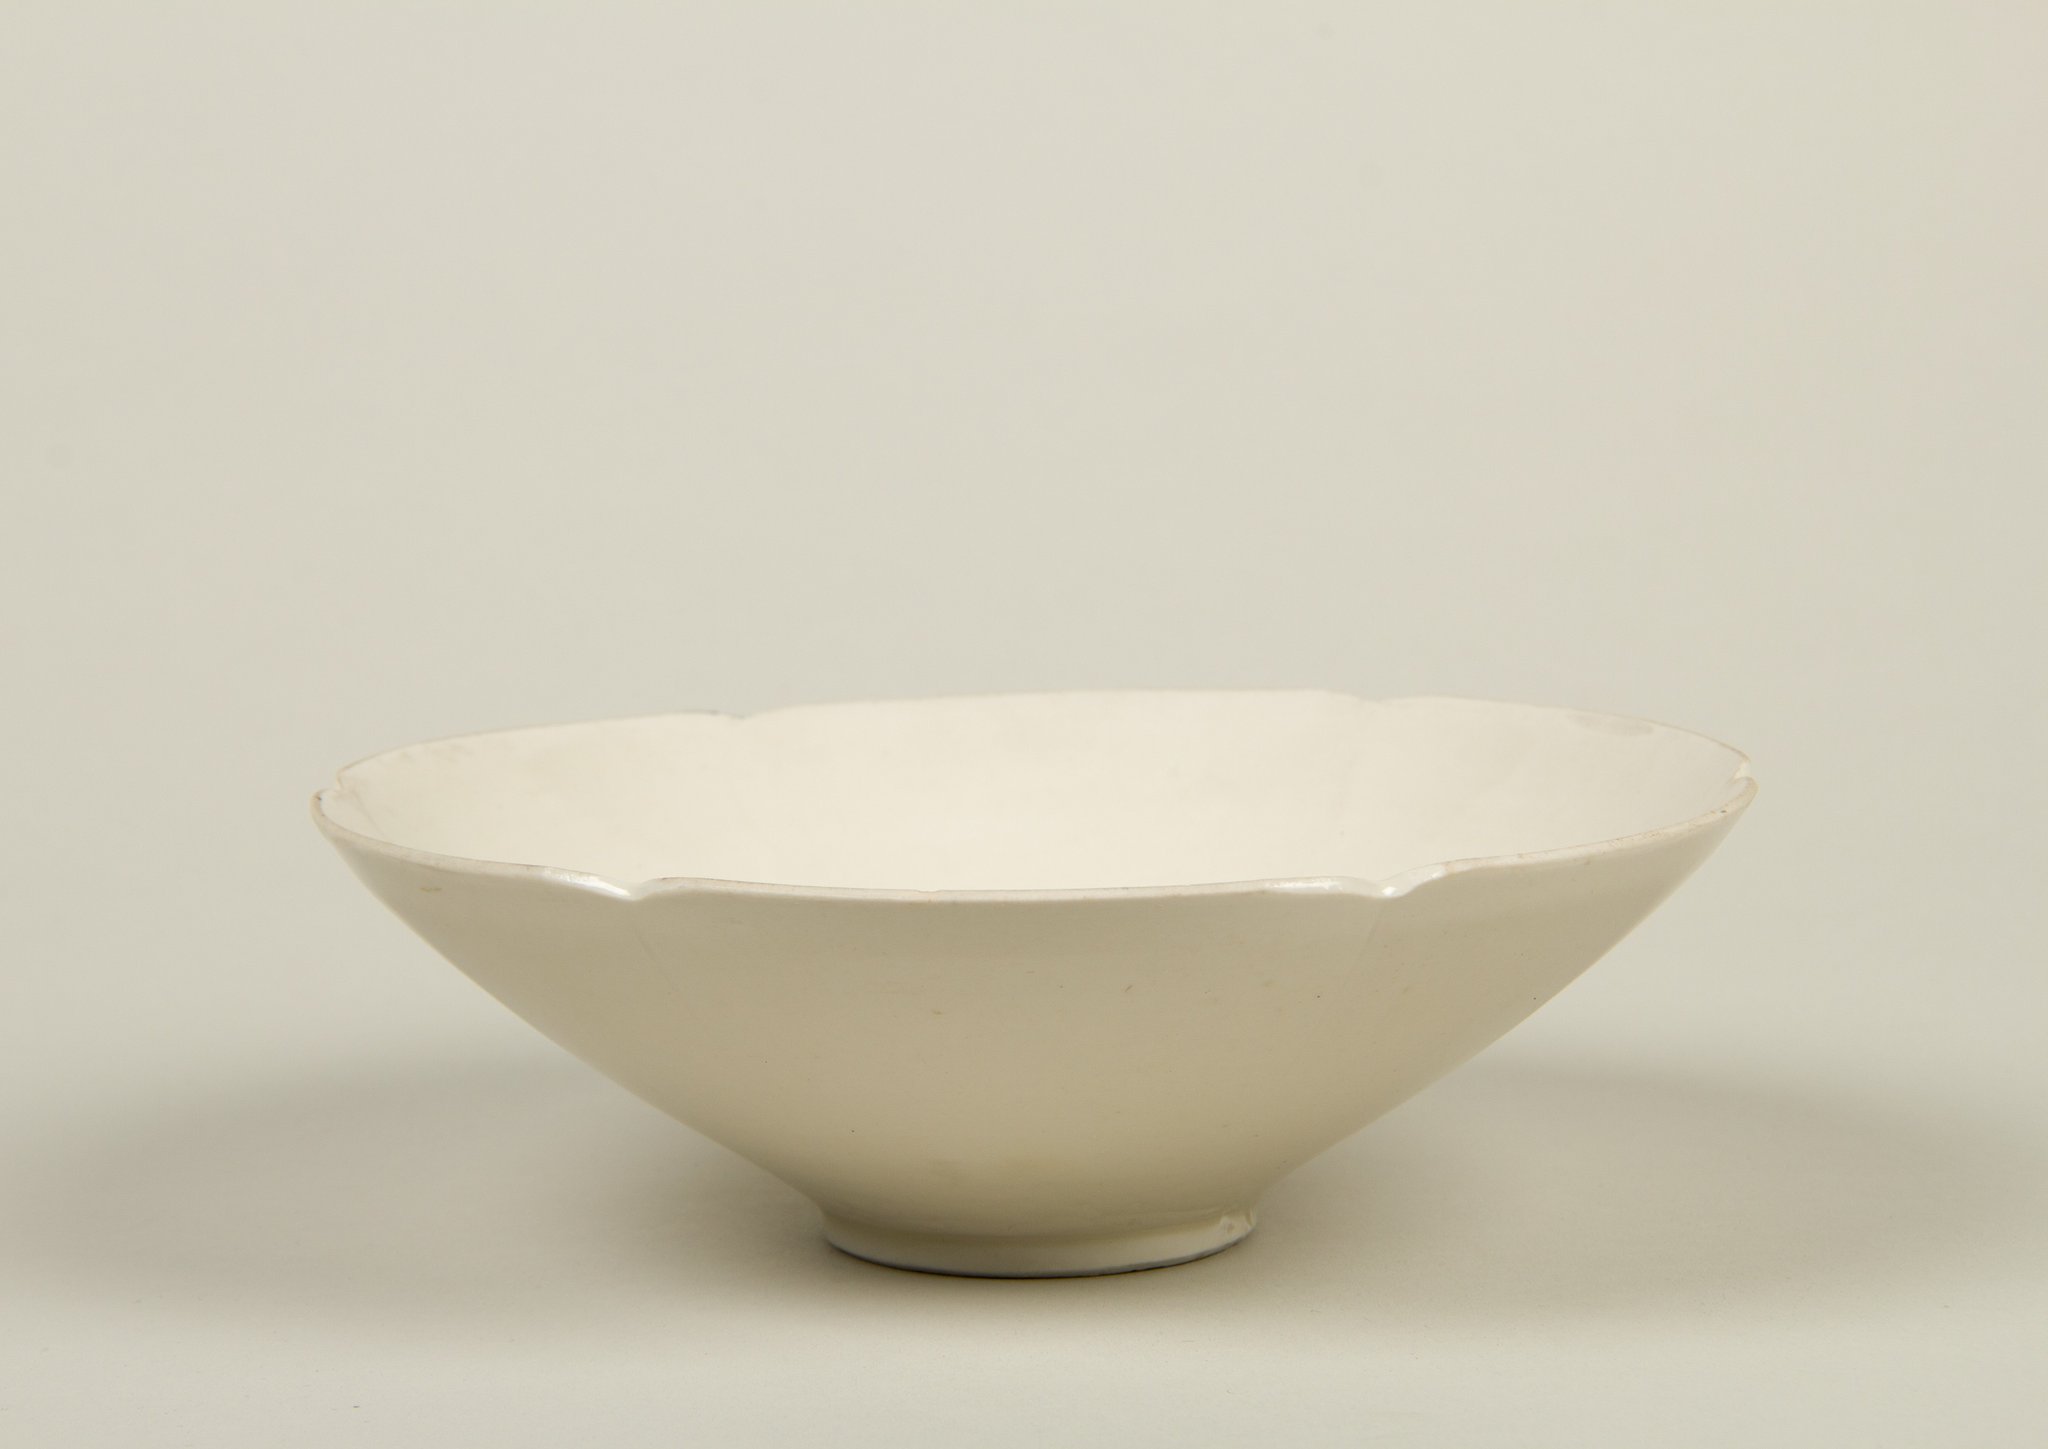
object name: bowl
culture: chinese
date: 901-1100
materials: glaze, ivory, porcelain